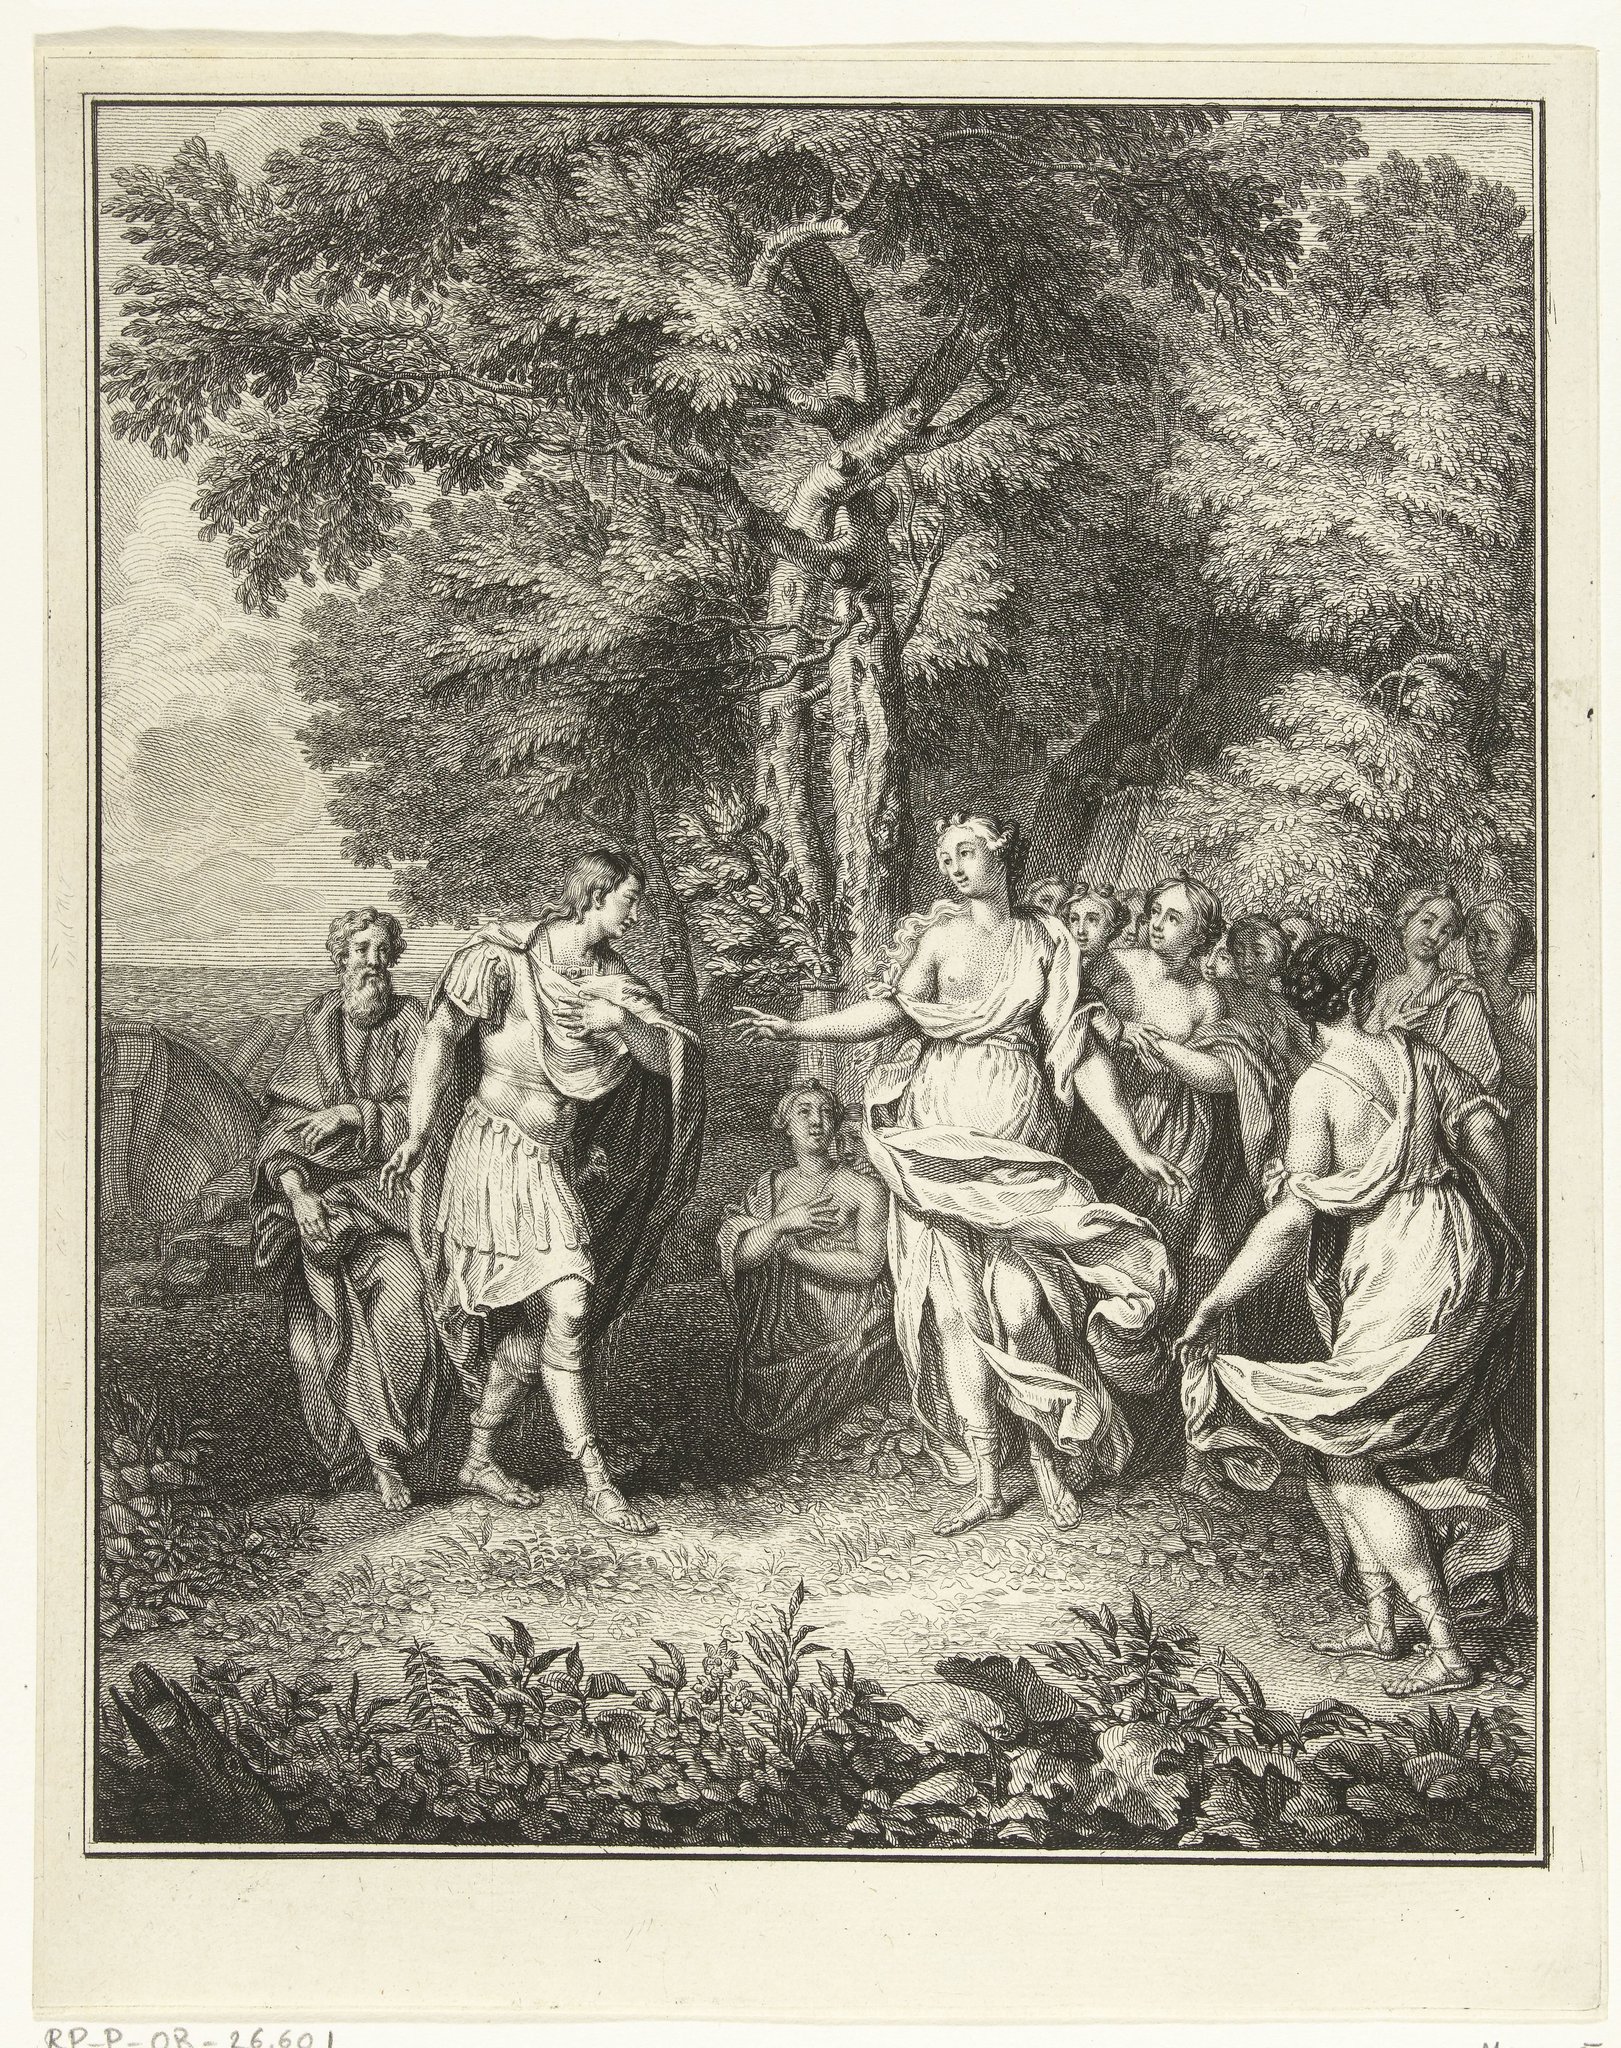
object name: book illustration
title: Calypso ontvangt Telemachus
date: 1734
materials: paper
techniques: engraving, etching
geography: amsterdam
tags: (story of) telemachus, telemachus and calypso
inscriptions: collector's mark: Lugt 2228, collector's mark: Lugt 240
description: Telemachus die na een schipbreuk het eiland van de godin Calypso heeft bereikt wordt door haar en haar nimfen ontvangen. Achter hem loopt zijn leidsman Mentor. Op de achtergrond is links nog het zinkende schip te zien.